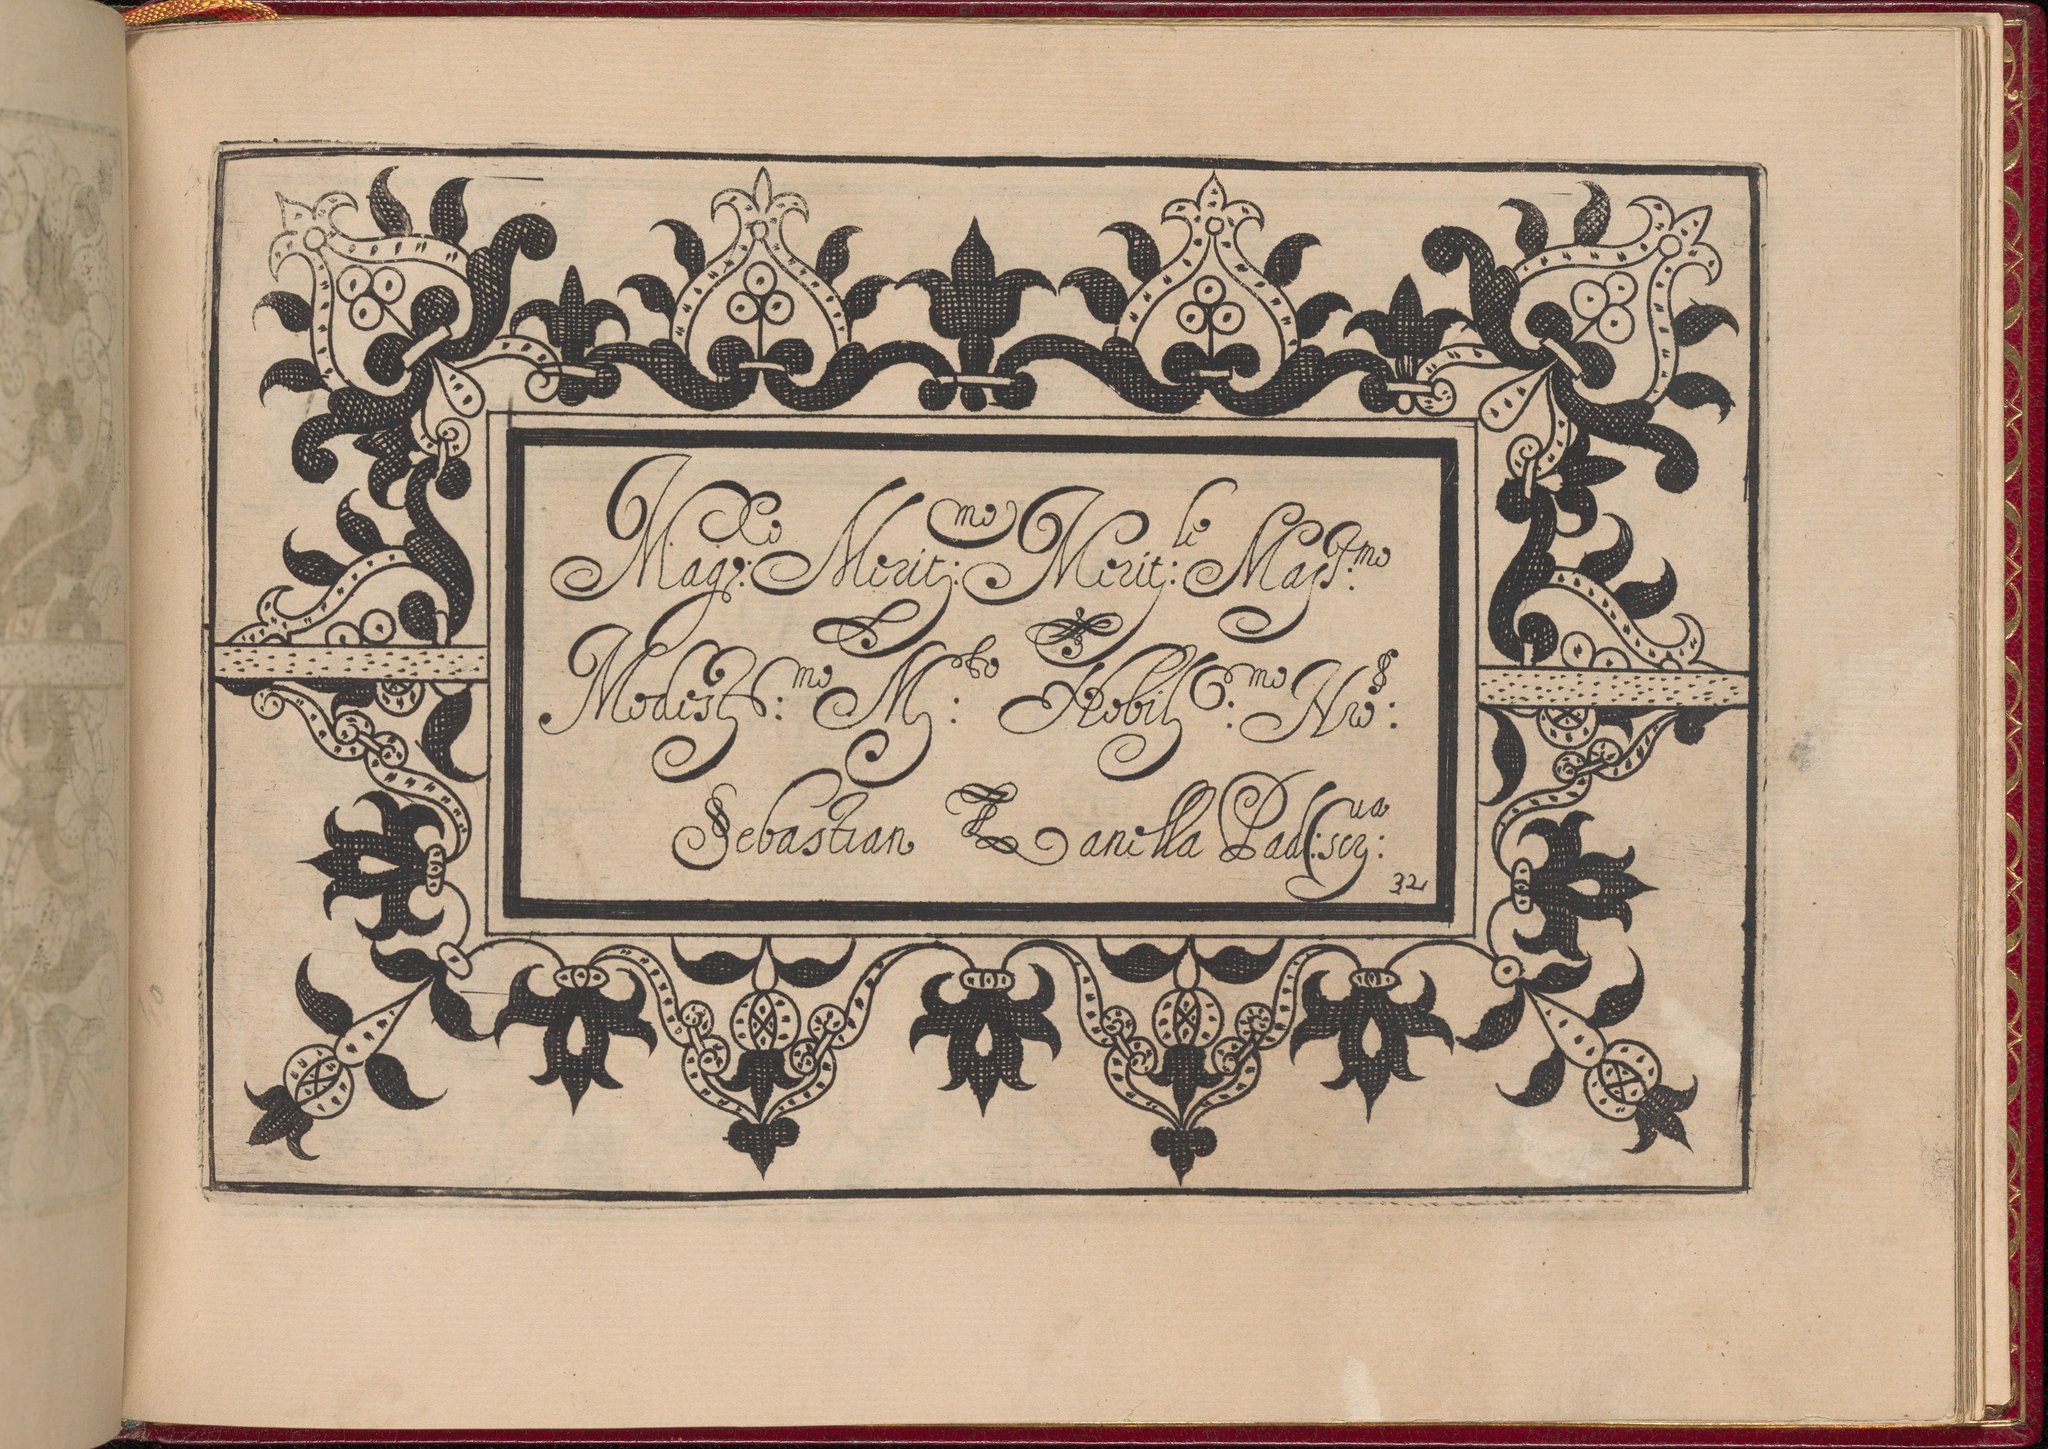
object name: book print ornament architecture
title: Ghirlanda: Di sei vaghi fiori scielti da piu famosi Giardini d'Italia, page 40 (recto)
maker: pietro paulo tozzi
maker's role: designer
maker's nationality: italian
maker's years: 1593-1628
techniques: drawing, etching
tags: vines